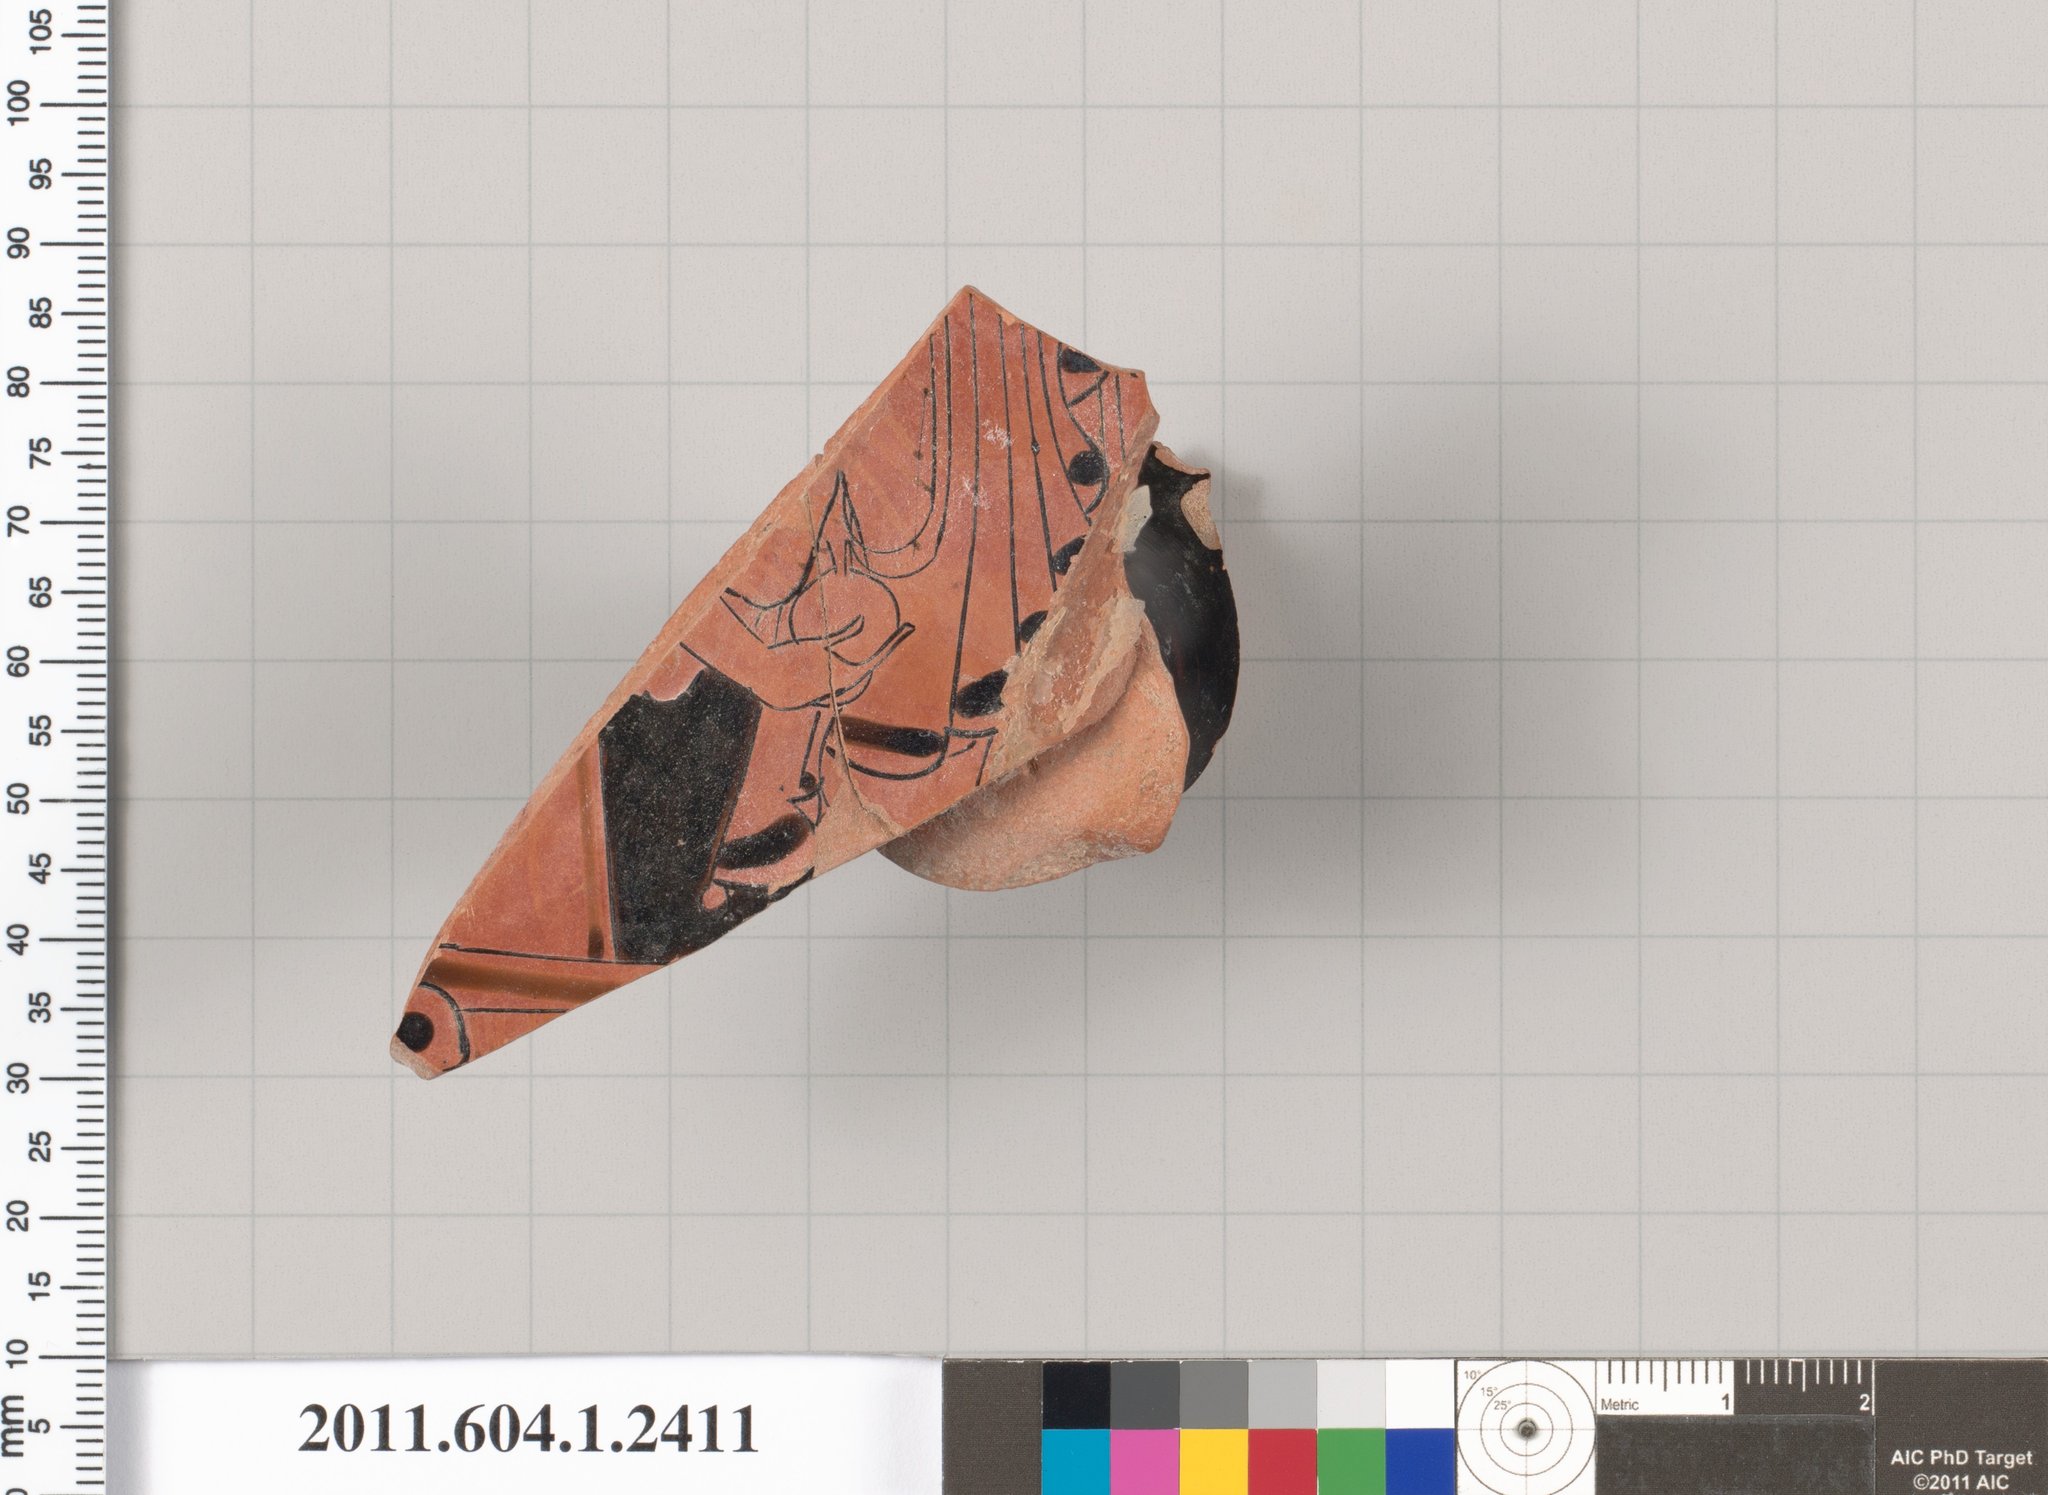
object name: kylix fragment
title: Terracotta fragment of a kylix (drinking cup)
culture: greek, attic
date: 490-480 BCE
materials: terracotta